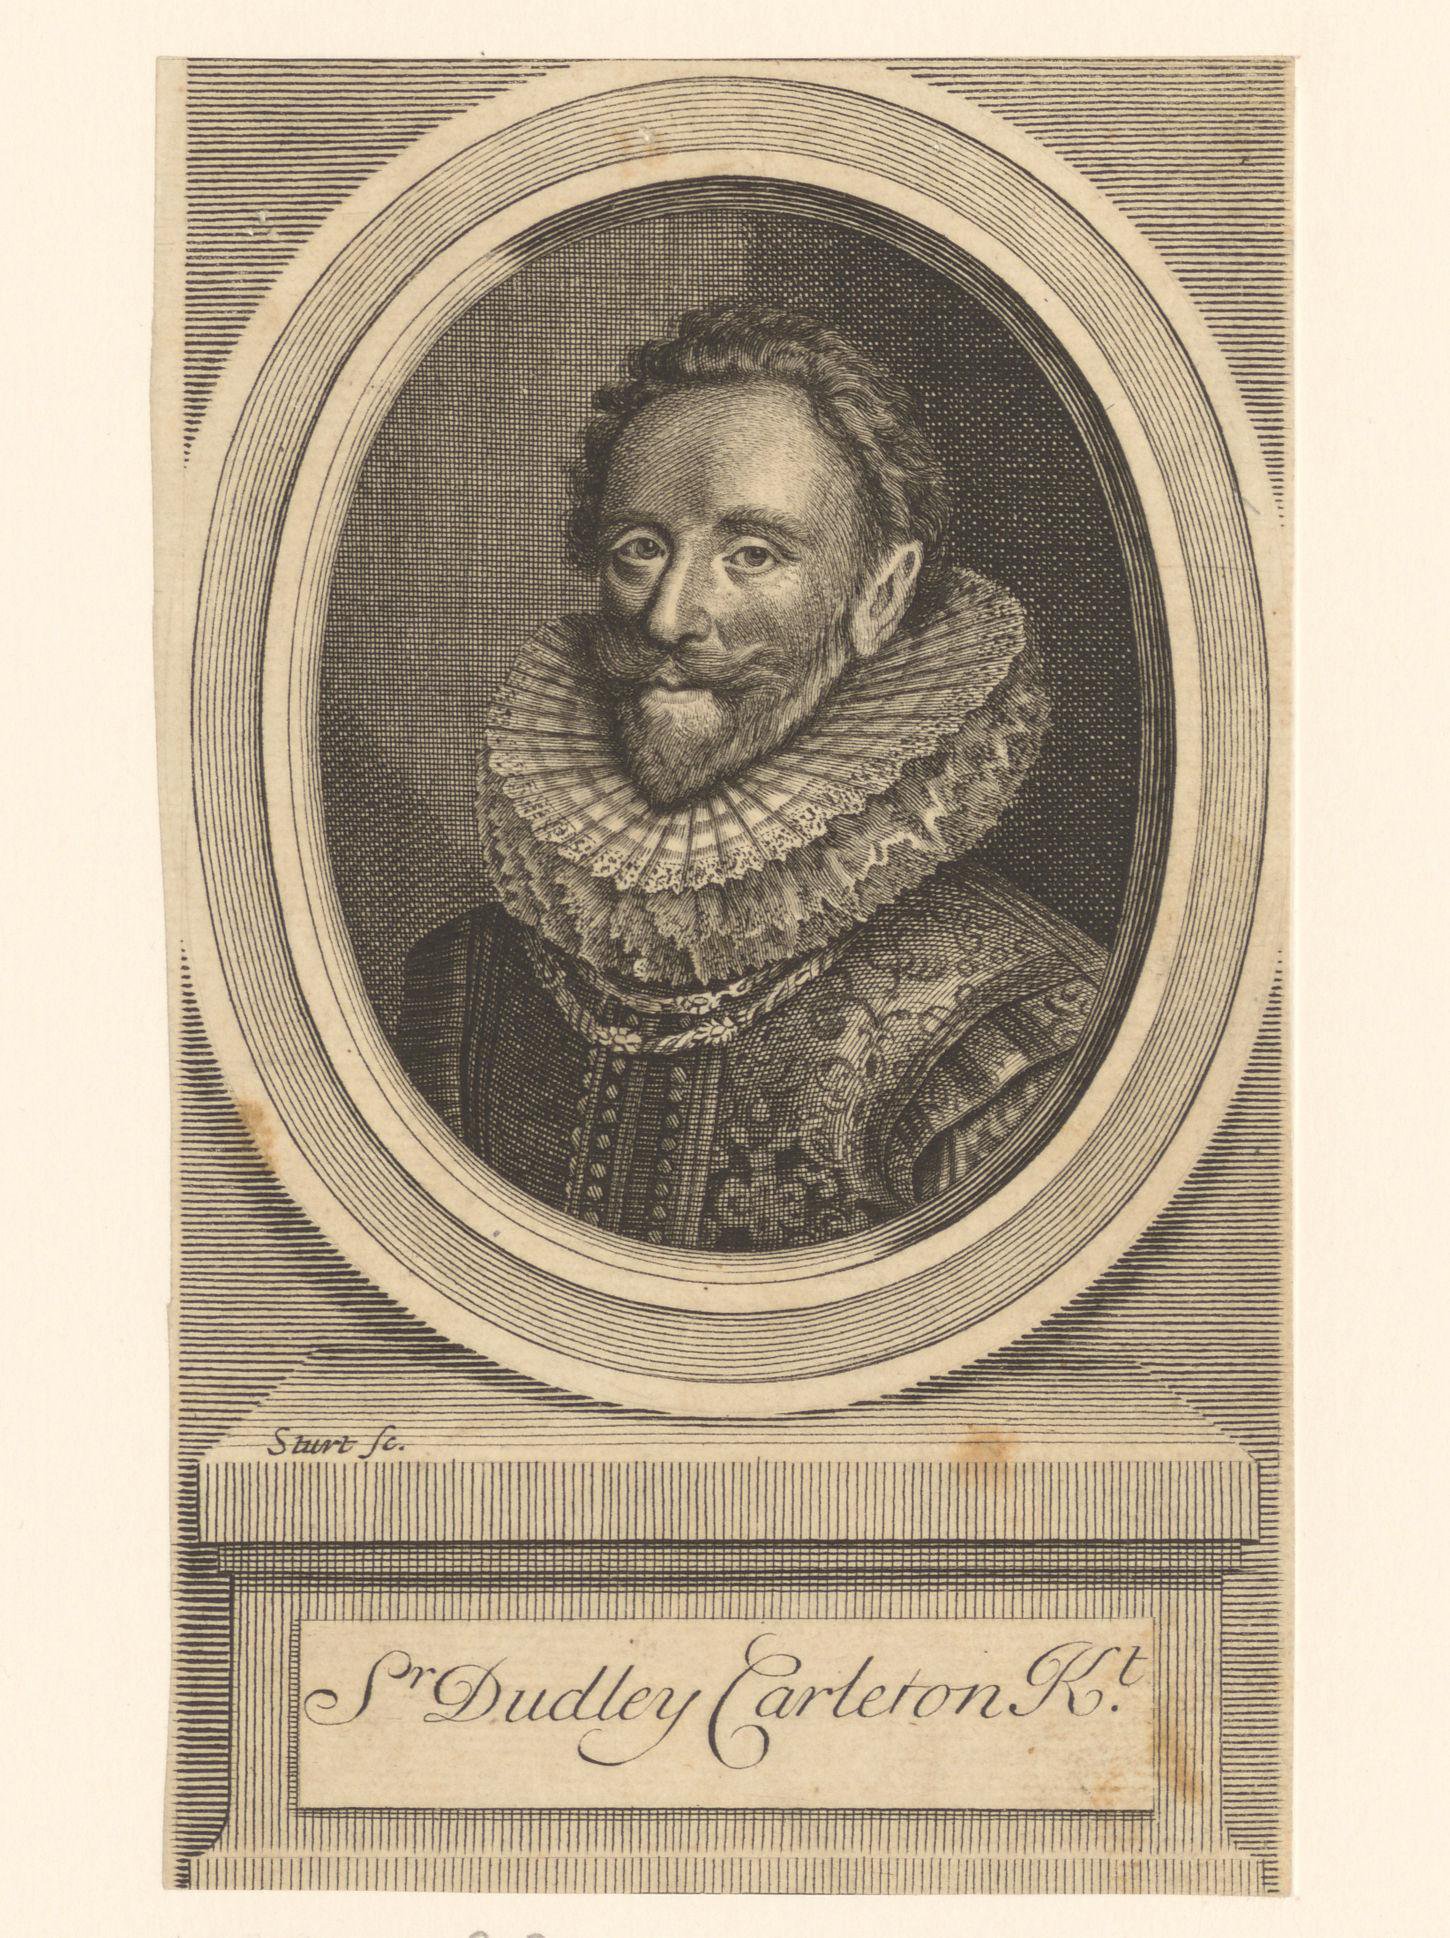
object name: book illustration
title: Portret van Dudley Carleton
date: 1713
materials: paper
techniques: engraving, etching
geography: london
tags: historical persons, diplomacy, diplomat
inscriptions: collector's mark: Lugt 2228, inscription: ‘3d’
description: Prent uit: Ward, Edward. History of the Grand Rebellion (...). Londen: John Morphew, 1713, dl. 1.